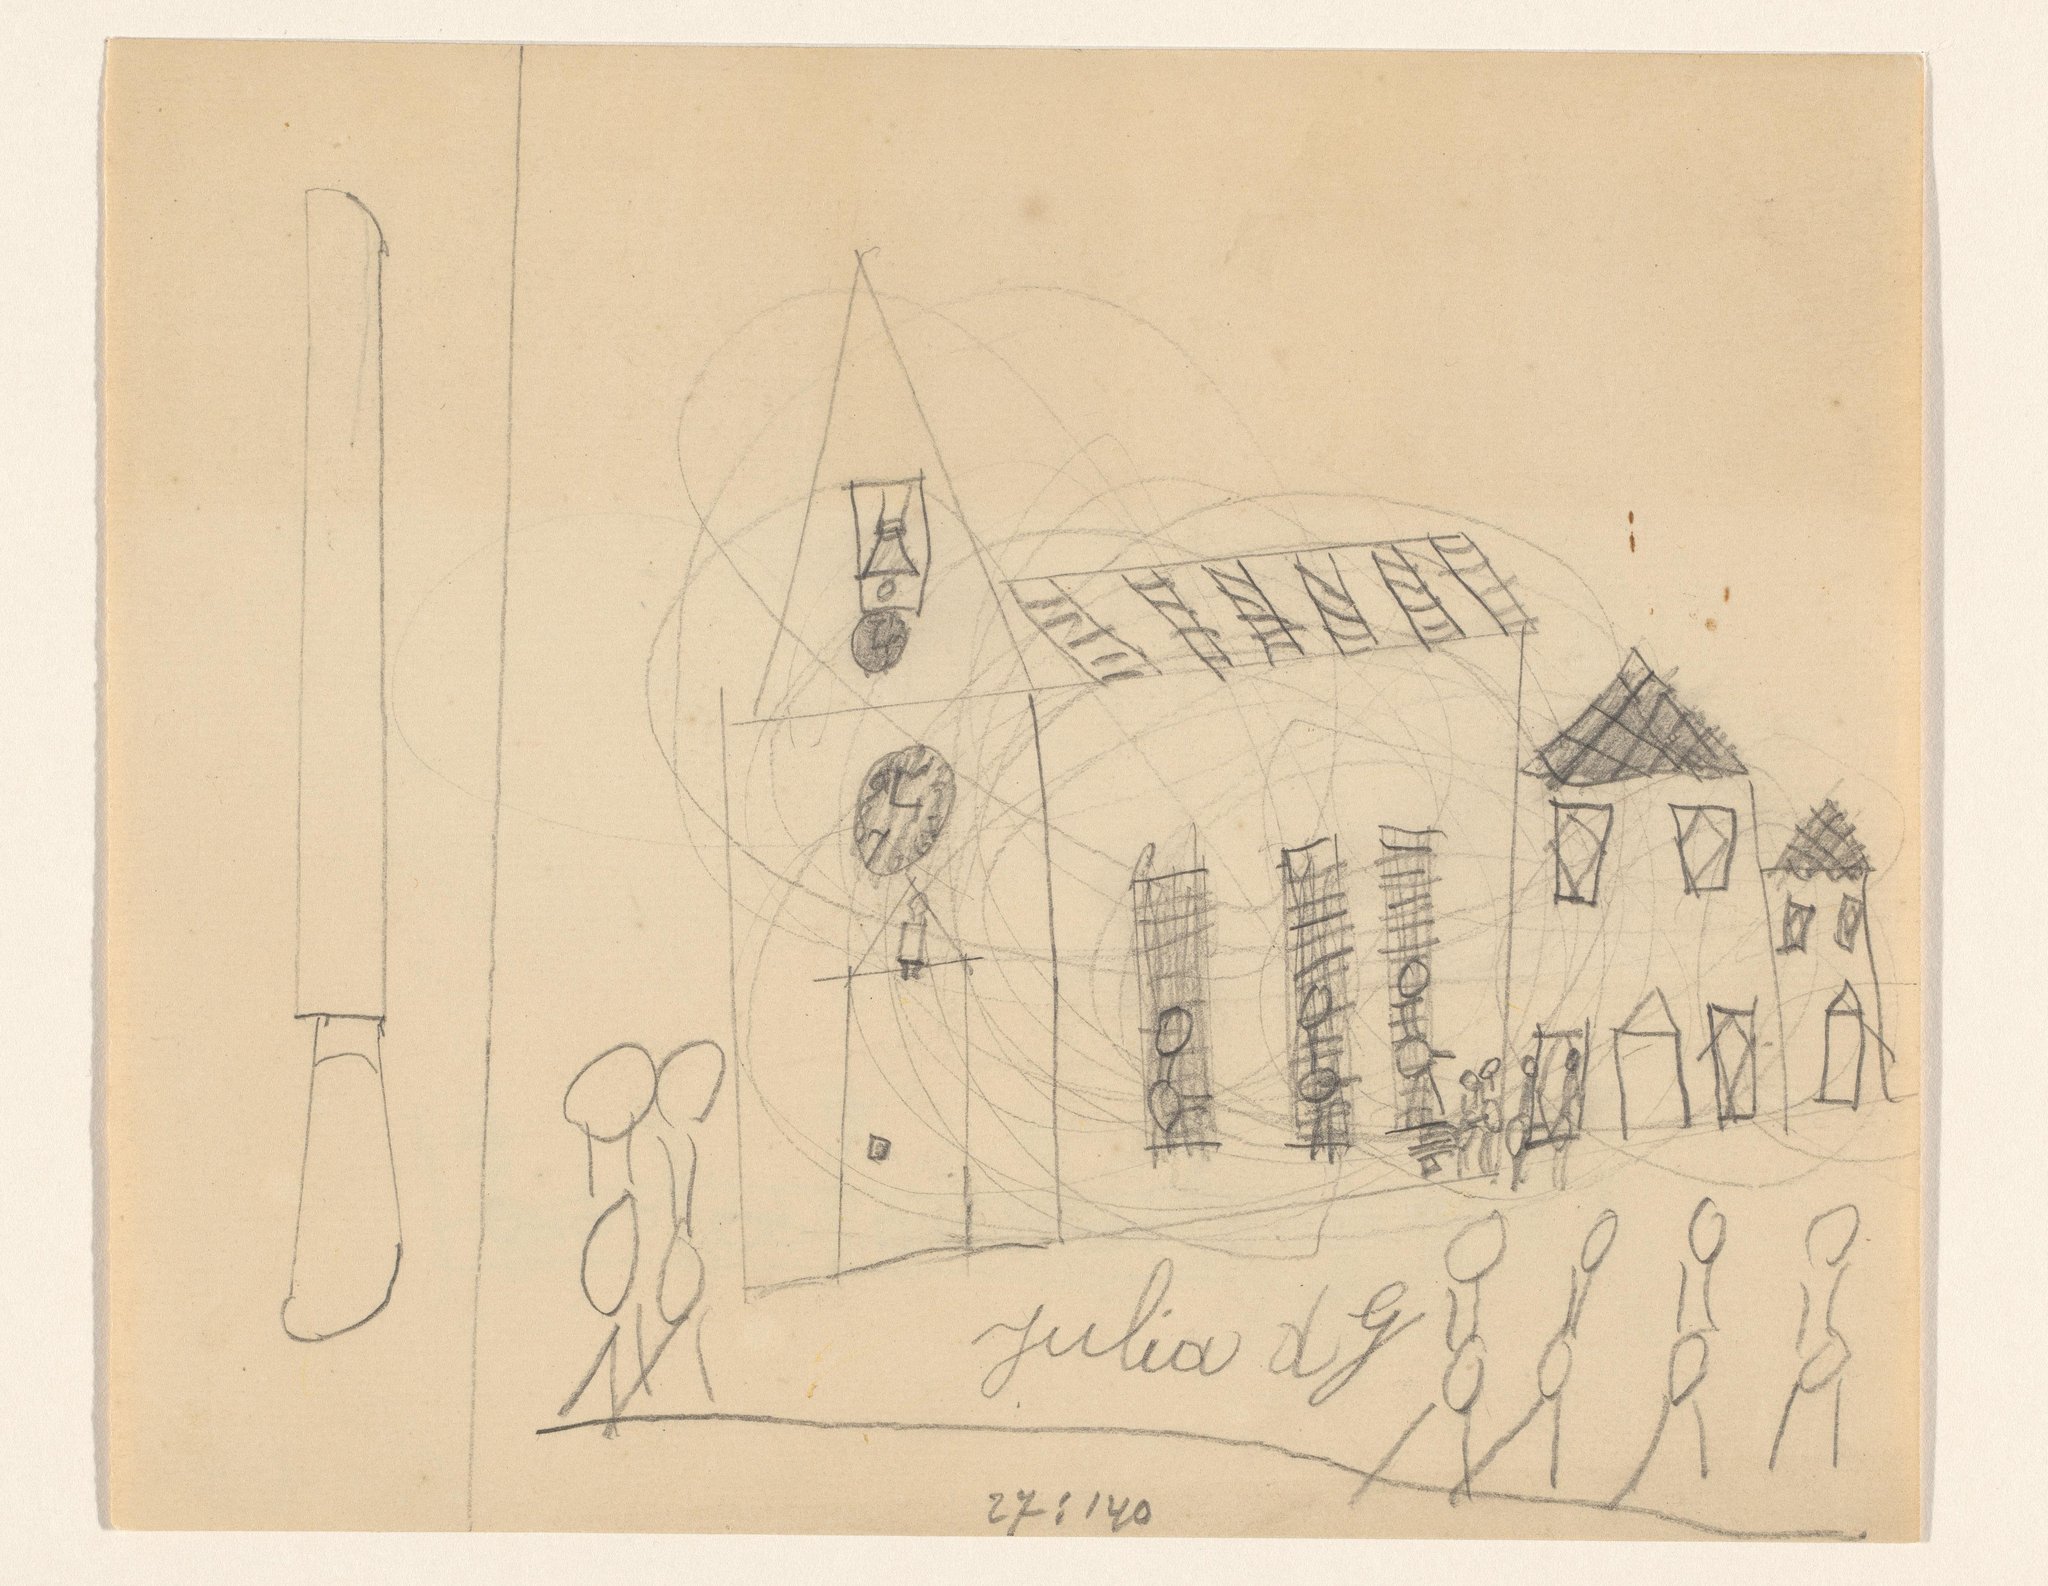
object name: drawing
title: Kerk en figuren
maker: julie de graag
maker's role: draughtsman, print maker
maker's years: 1877-1924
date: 1880-1887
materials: paper, pencil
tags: church (exterior)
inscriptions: number: ‘145’, annotation: ‘RP’